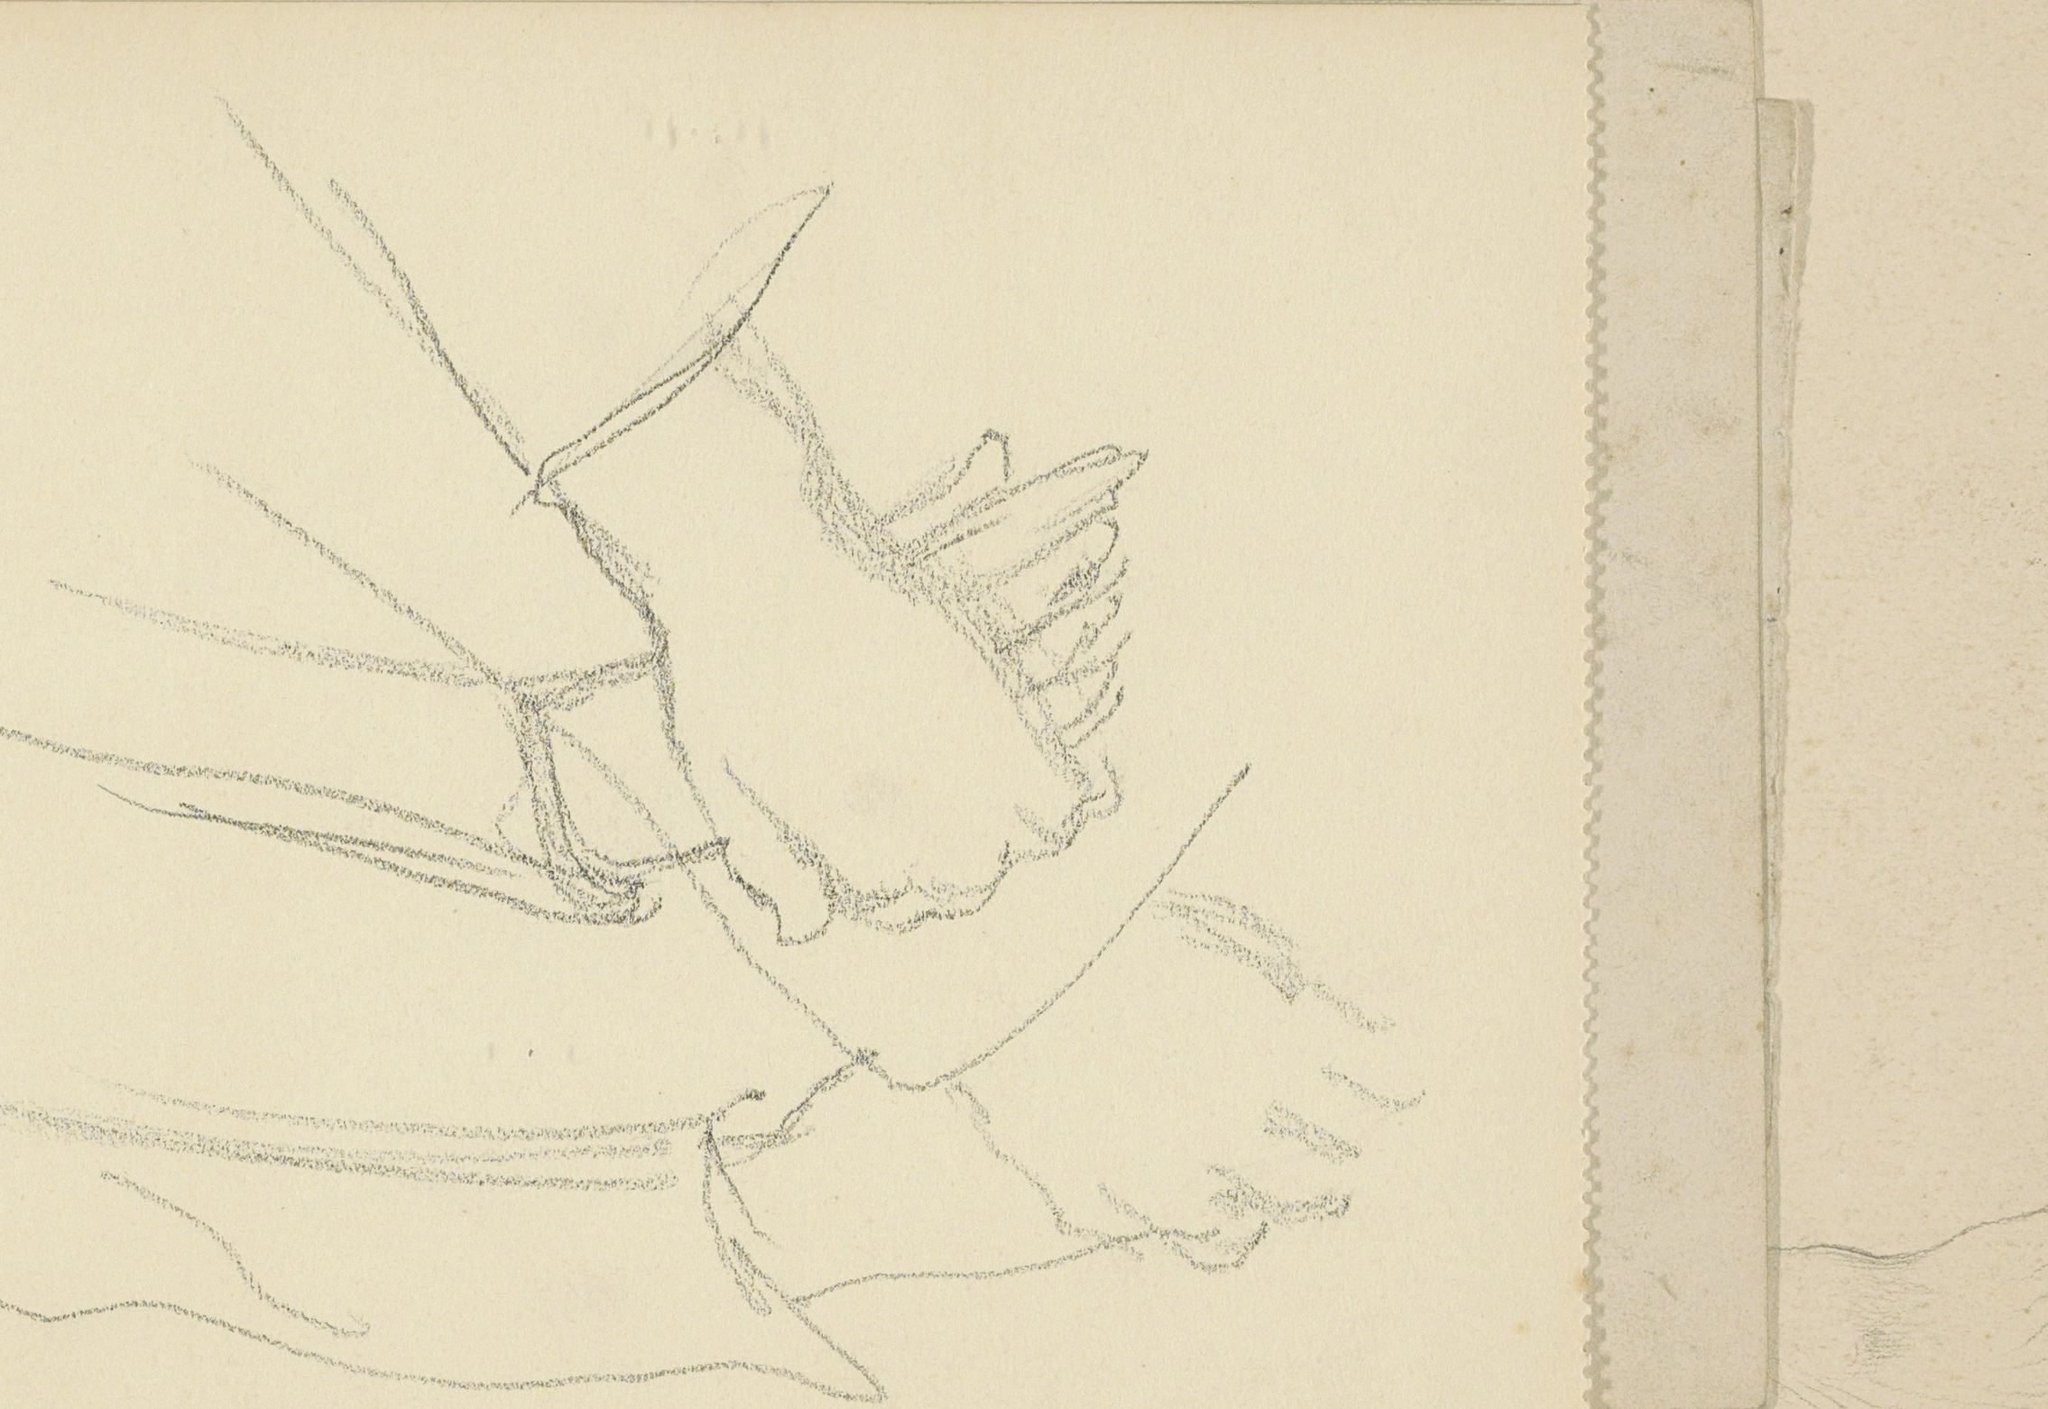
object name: sketchbook leaf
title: Twee paar voor het lichaam gevouwen handen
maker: antoon derkinderen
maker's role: draughtsman, painter, print maker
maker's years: 1859-1925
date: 1869-1925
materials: paper, pencil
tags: hands folded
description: Recto van een losse tekening tussen het voorste schutblad en blad 1 uit een schetsboek met 28 bladen.